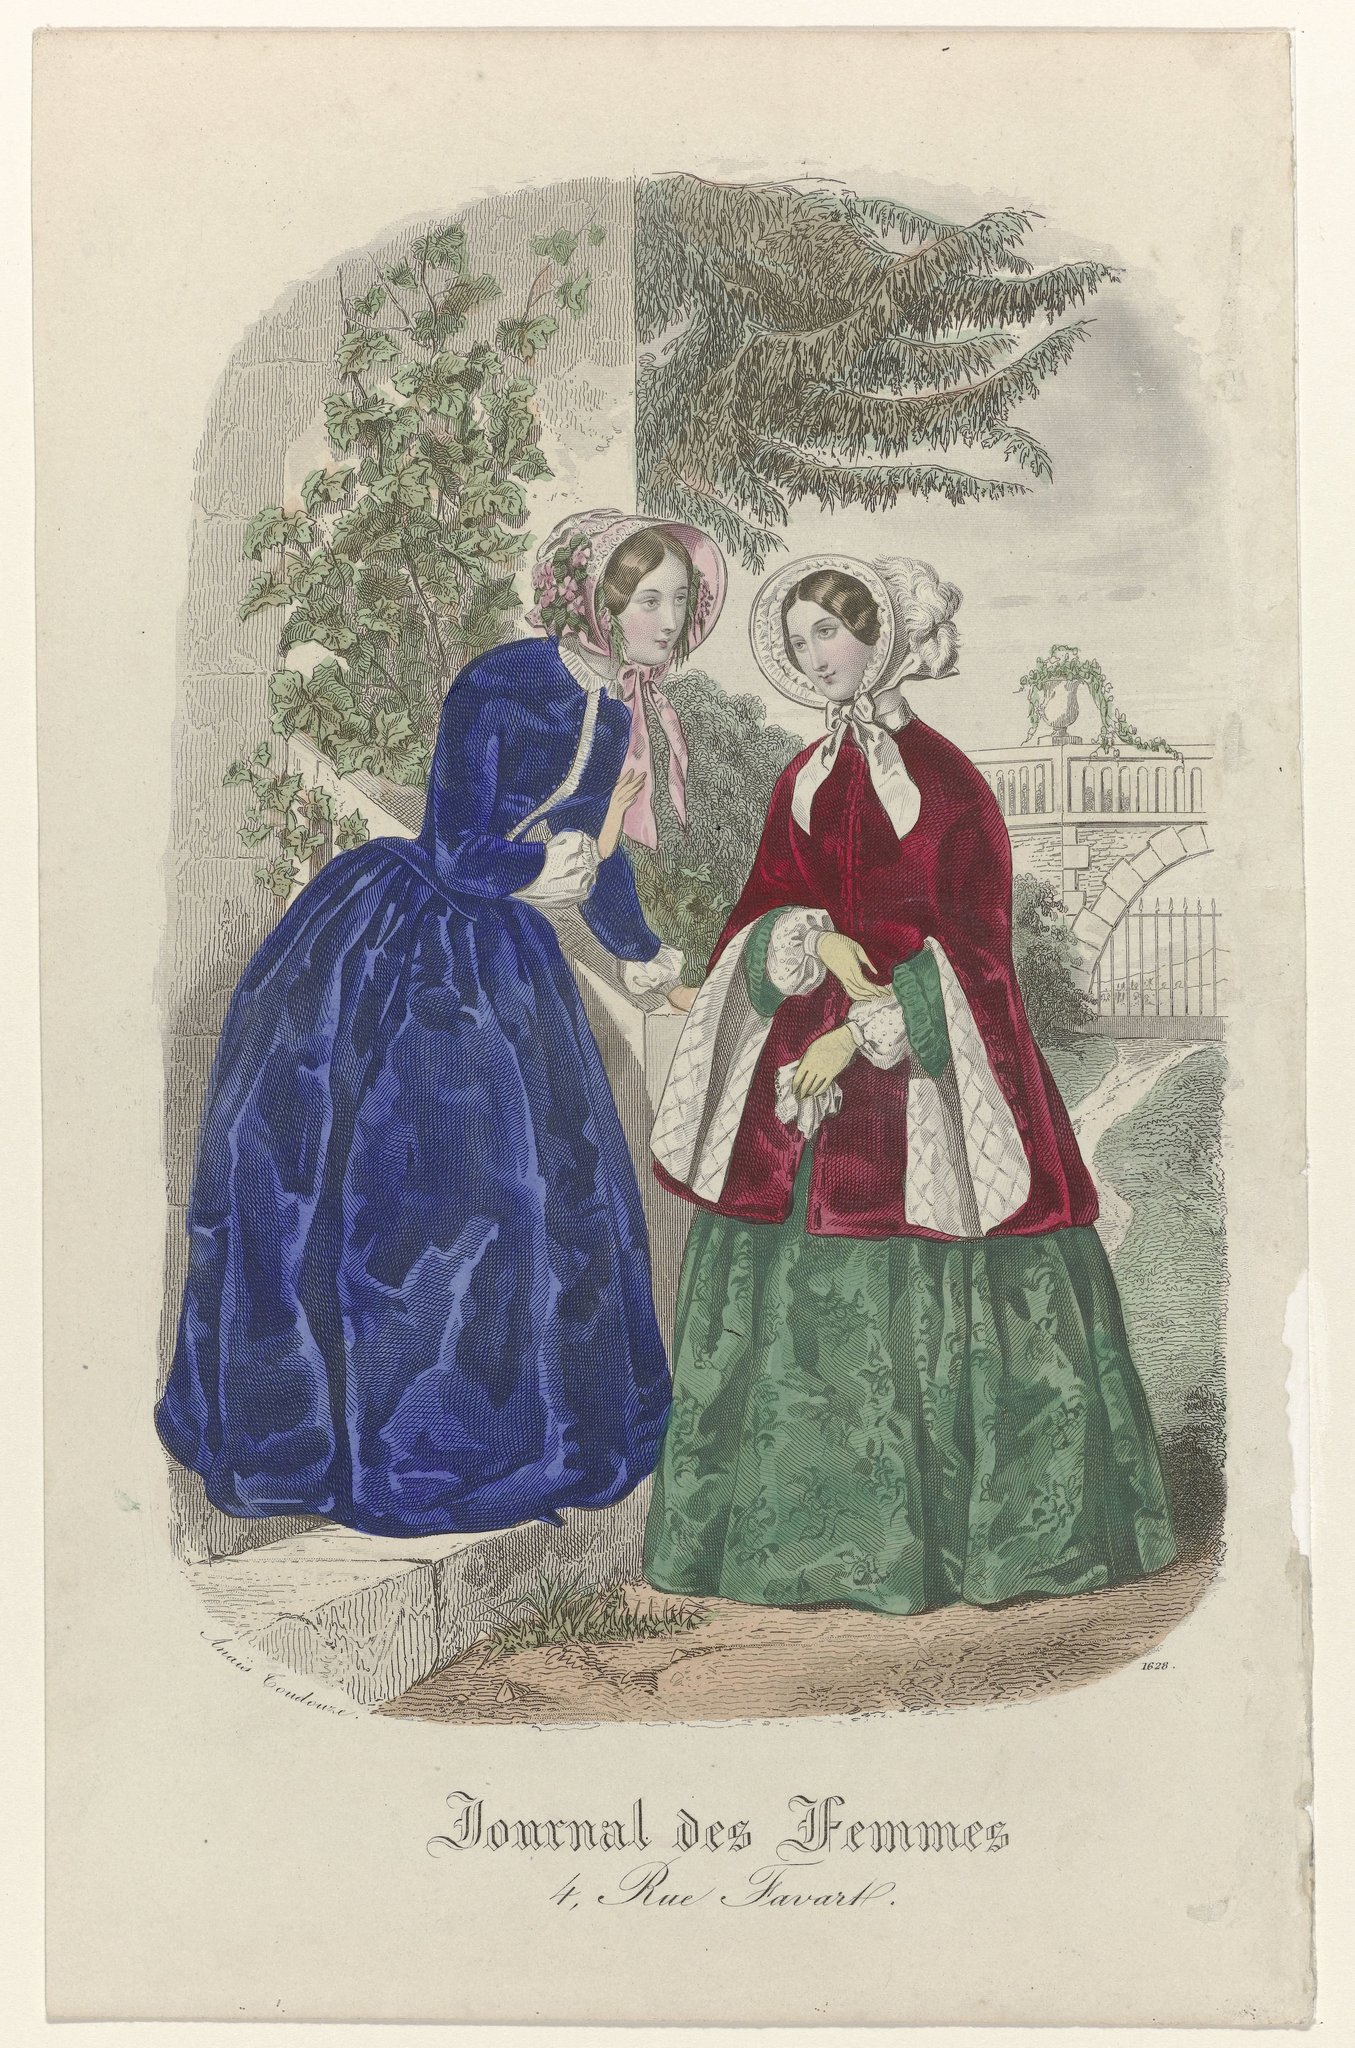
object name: fashion print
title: Journal des Femmes, ca. 1850, Pl. 1628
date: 1850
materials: paper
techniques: engraving, hand coloring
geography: paris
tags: handkerchief (+ women's clothes), coat (+ women's clothes), fashion plates, head-gear: hat (+ women's clothes), skirt (+ women's clothes), gloves, mittens, etc. (+ women's clothes)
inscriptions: address: ‘4, Rue Favart.’, title: ‘Journal des Femmes’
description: Twee vrouwen onder aan een trap in een ommuurde tuin. Links: blauwe japon met driekwart mouwen en poffende ondermouwen. Hoed met striklinten en versierd met bloemen. Rechts: rode mantel met wijde openvallende mouwen waardoor de contrasterende voering te zien is. Prent uit het modetijdschrift Journal des Femmes (1840-1851).